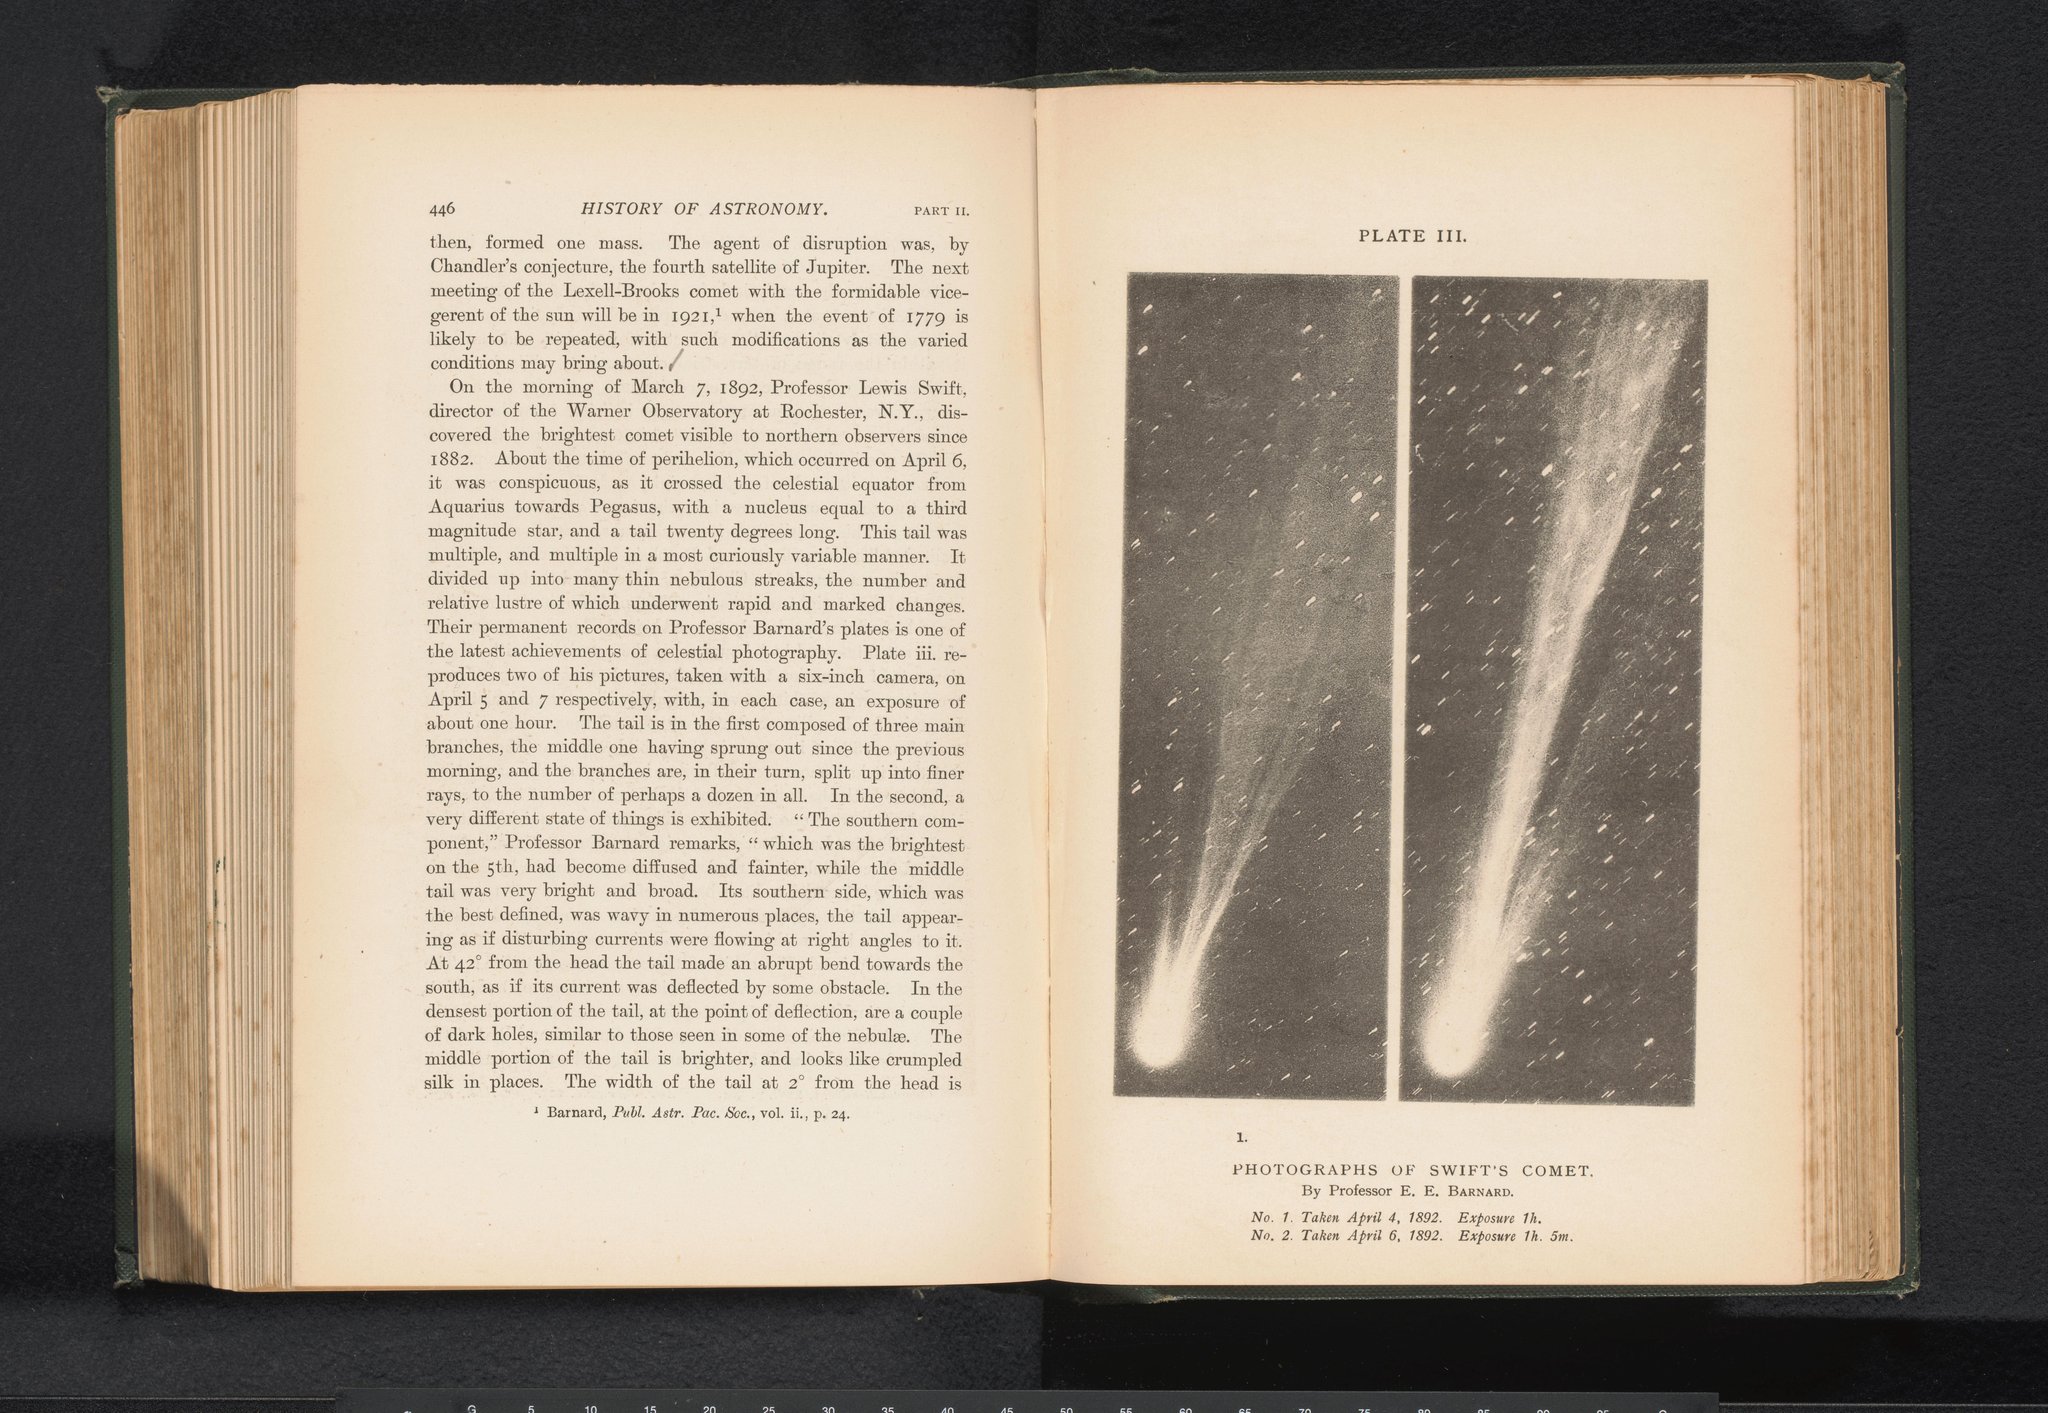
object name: photomechanical print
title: Photographs of Swift's comet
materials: paper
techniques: photograph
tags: comet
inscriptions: number: ‘Plate III’, inscription: ‘No. 1. Taken April 4, 1892. Exposure 1h. No. 2. Taken April 6, 1892. Exposure 1h. 5m.’